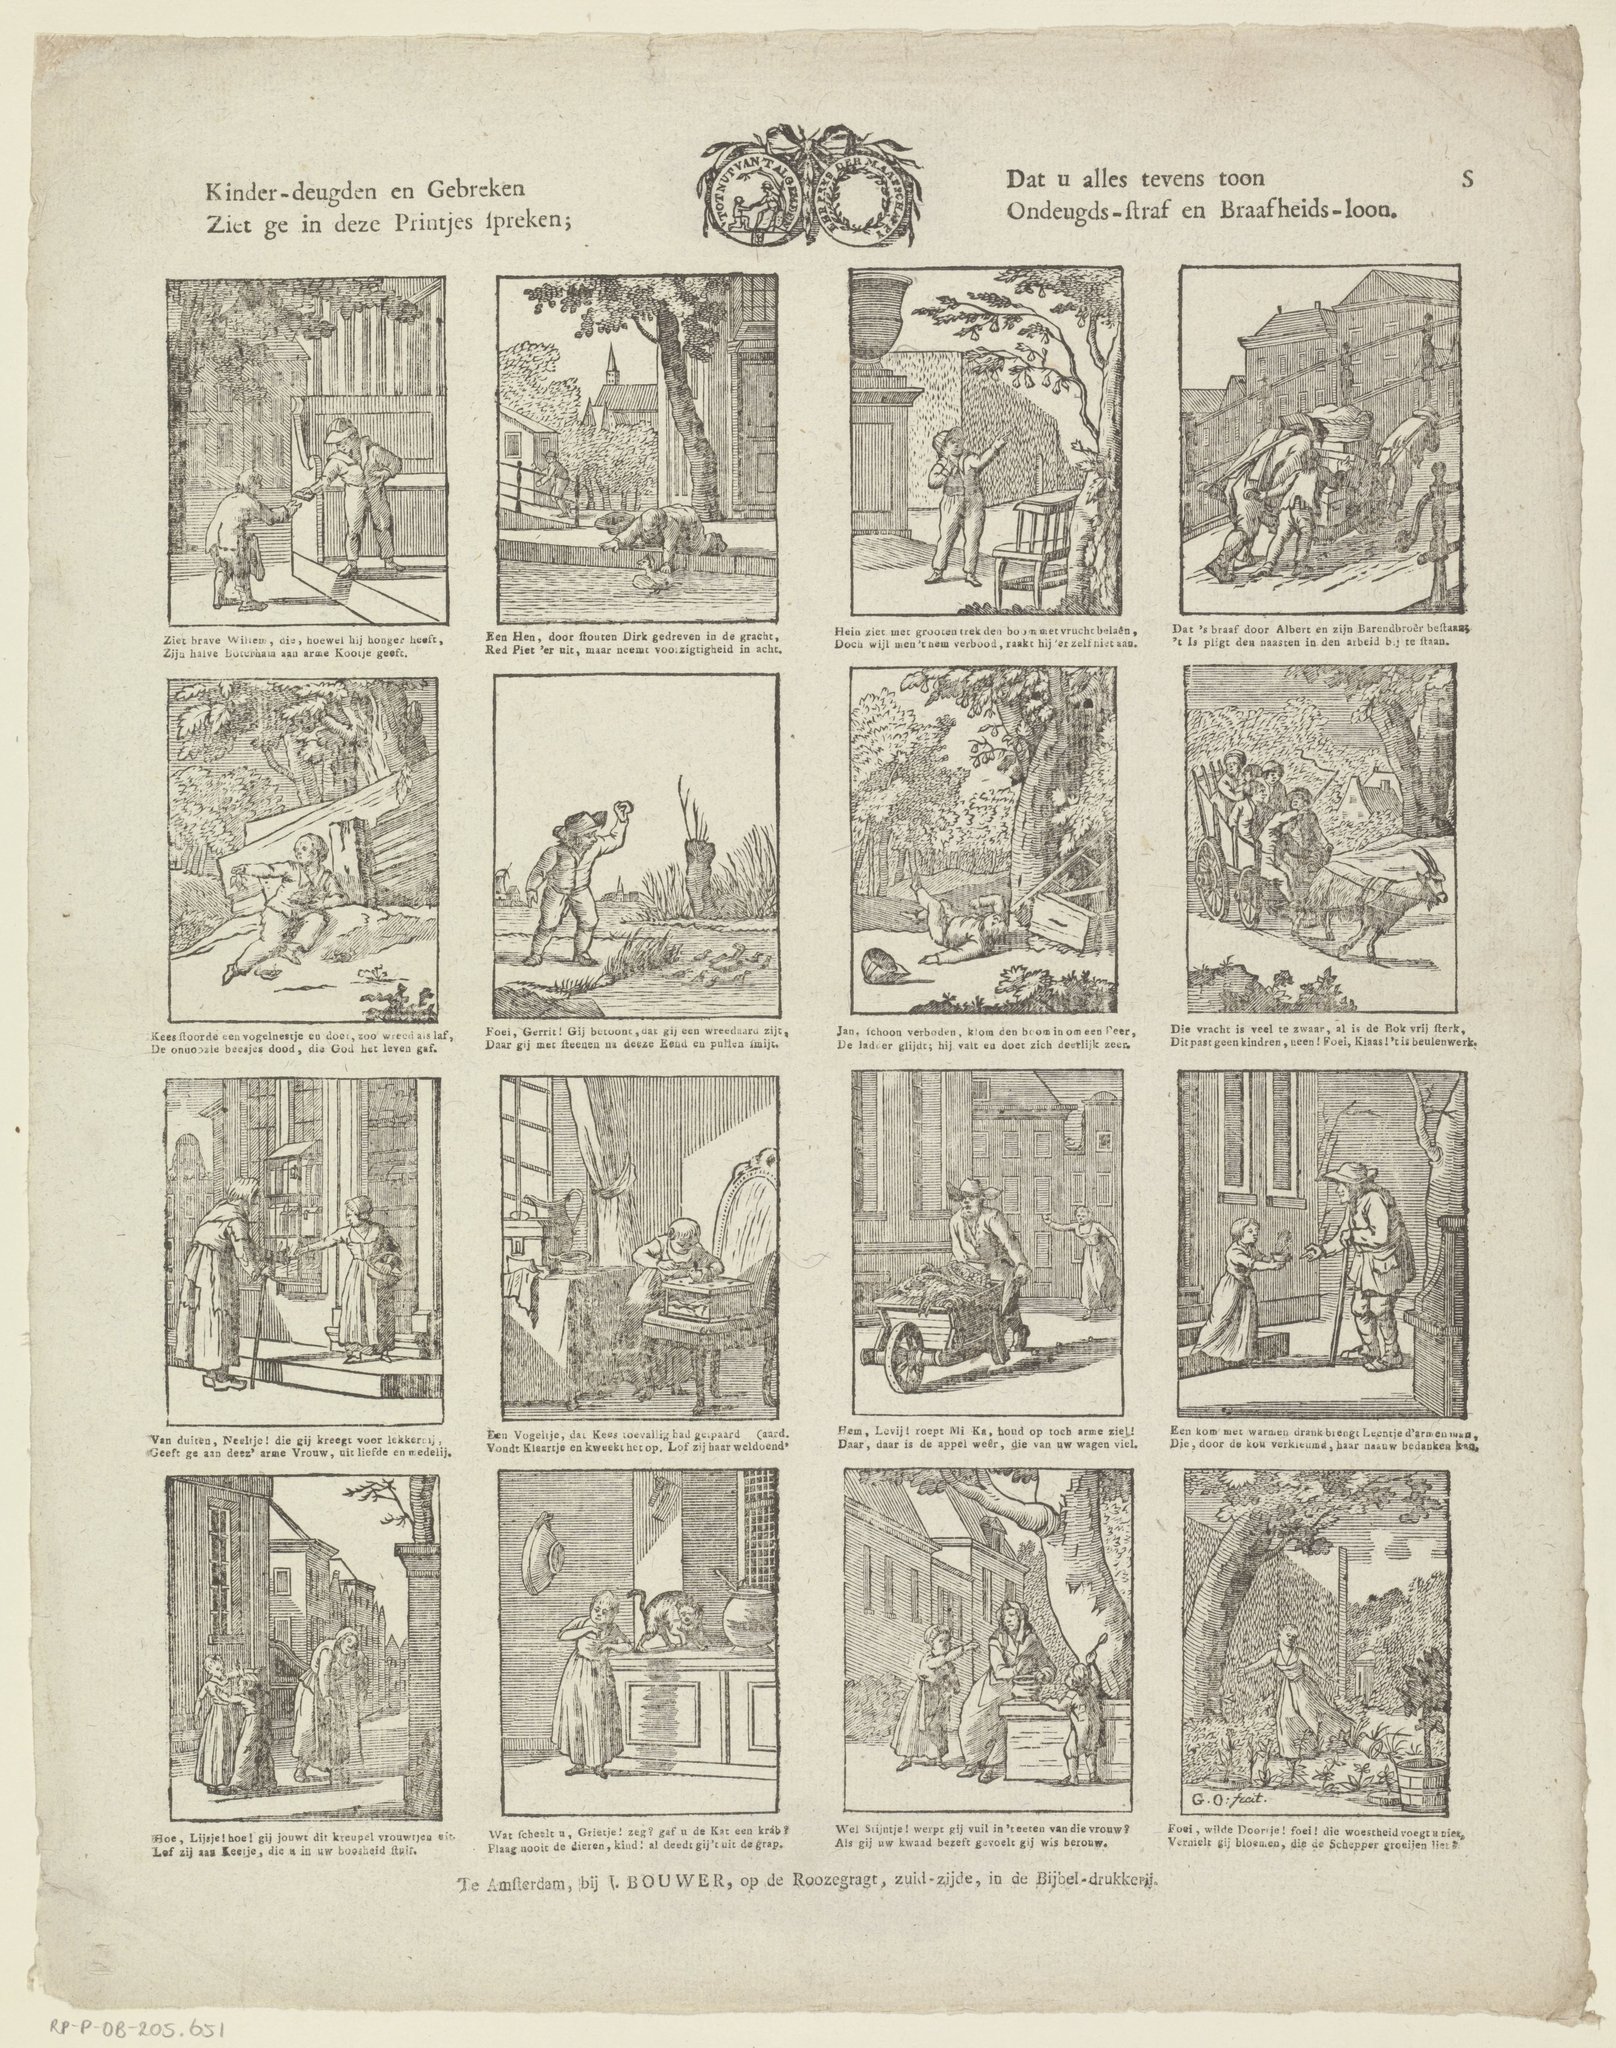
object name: popular print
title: Kinder-deugden en gebreken / Ziet ge in deze printjes spreken; / Dat u alles tevens toon / Ondeugds-straf en braafheids-loon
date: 1805-1808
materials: paper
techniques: letterpress printing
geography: amsterdam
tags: good and bad behaviour, moral qualities (opposing concepts) (+ situation or event (especially in genre-painting) with symbolical connotation), child (at home)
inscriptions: collector's mark: Lugt 2760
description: Blad met 12 voorstellingen van de beloning van gehoorzame kinderen en de bestraffing van ongehoorzame kinderen. Midden boven het zegel van de Maatschappij tot Nut van 't Algemeen. Onder elke afbeelding een tweeregelig ver. Genummerd rechtsboven: S.